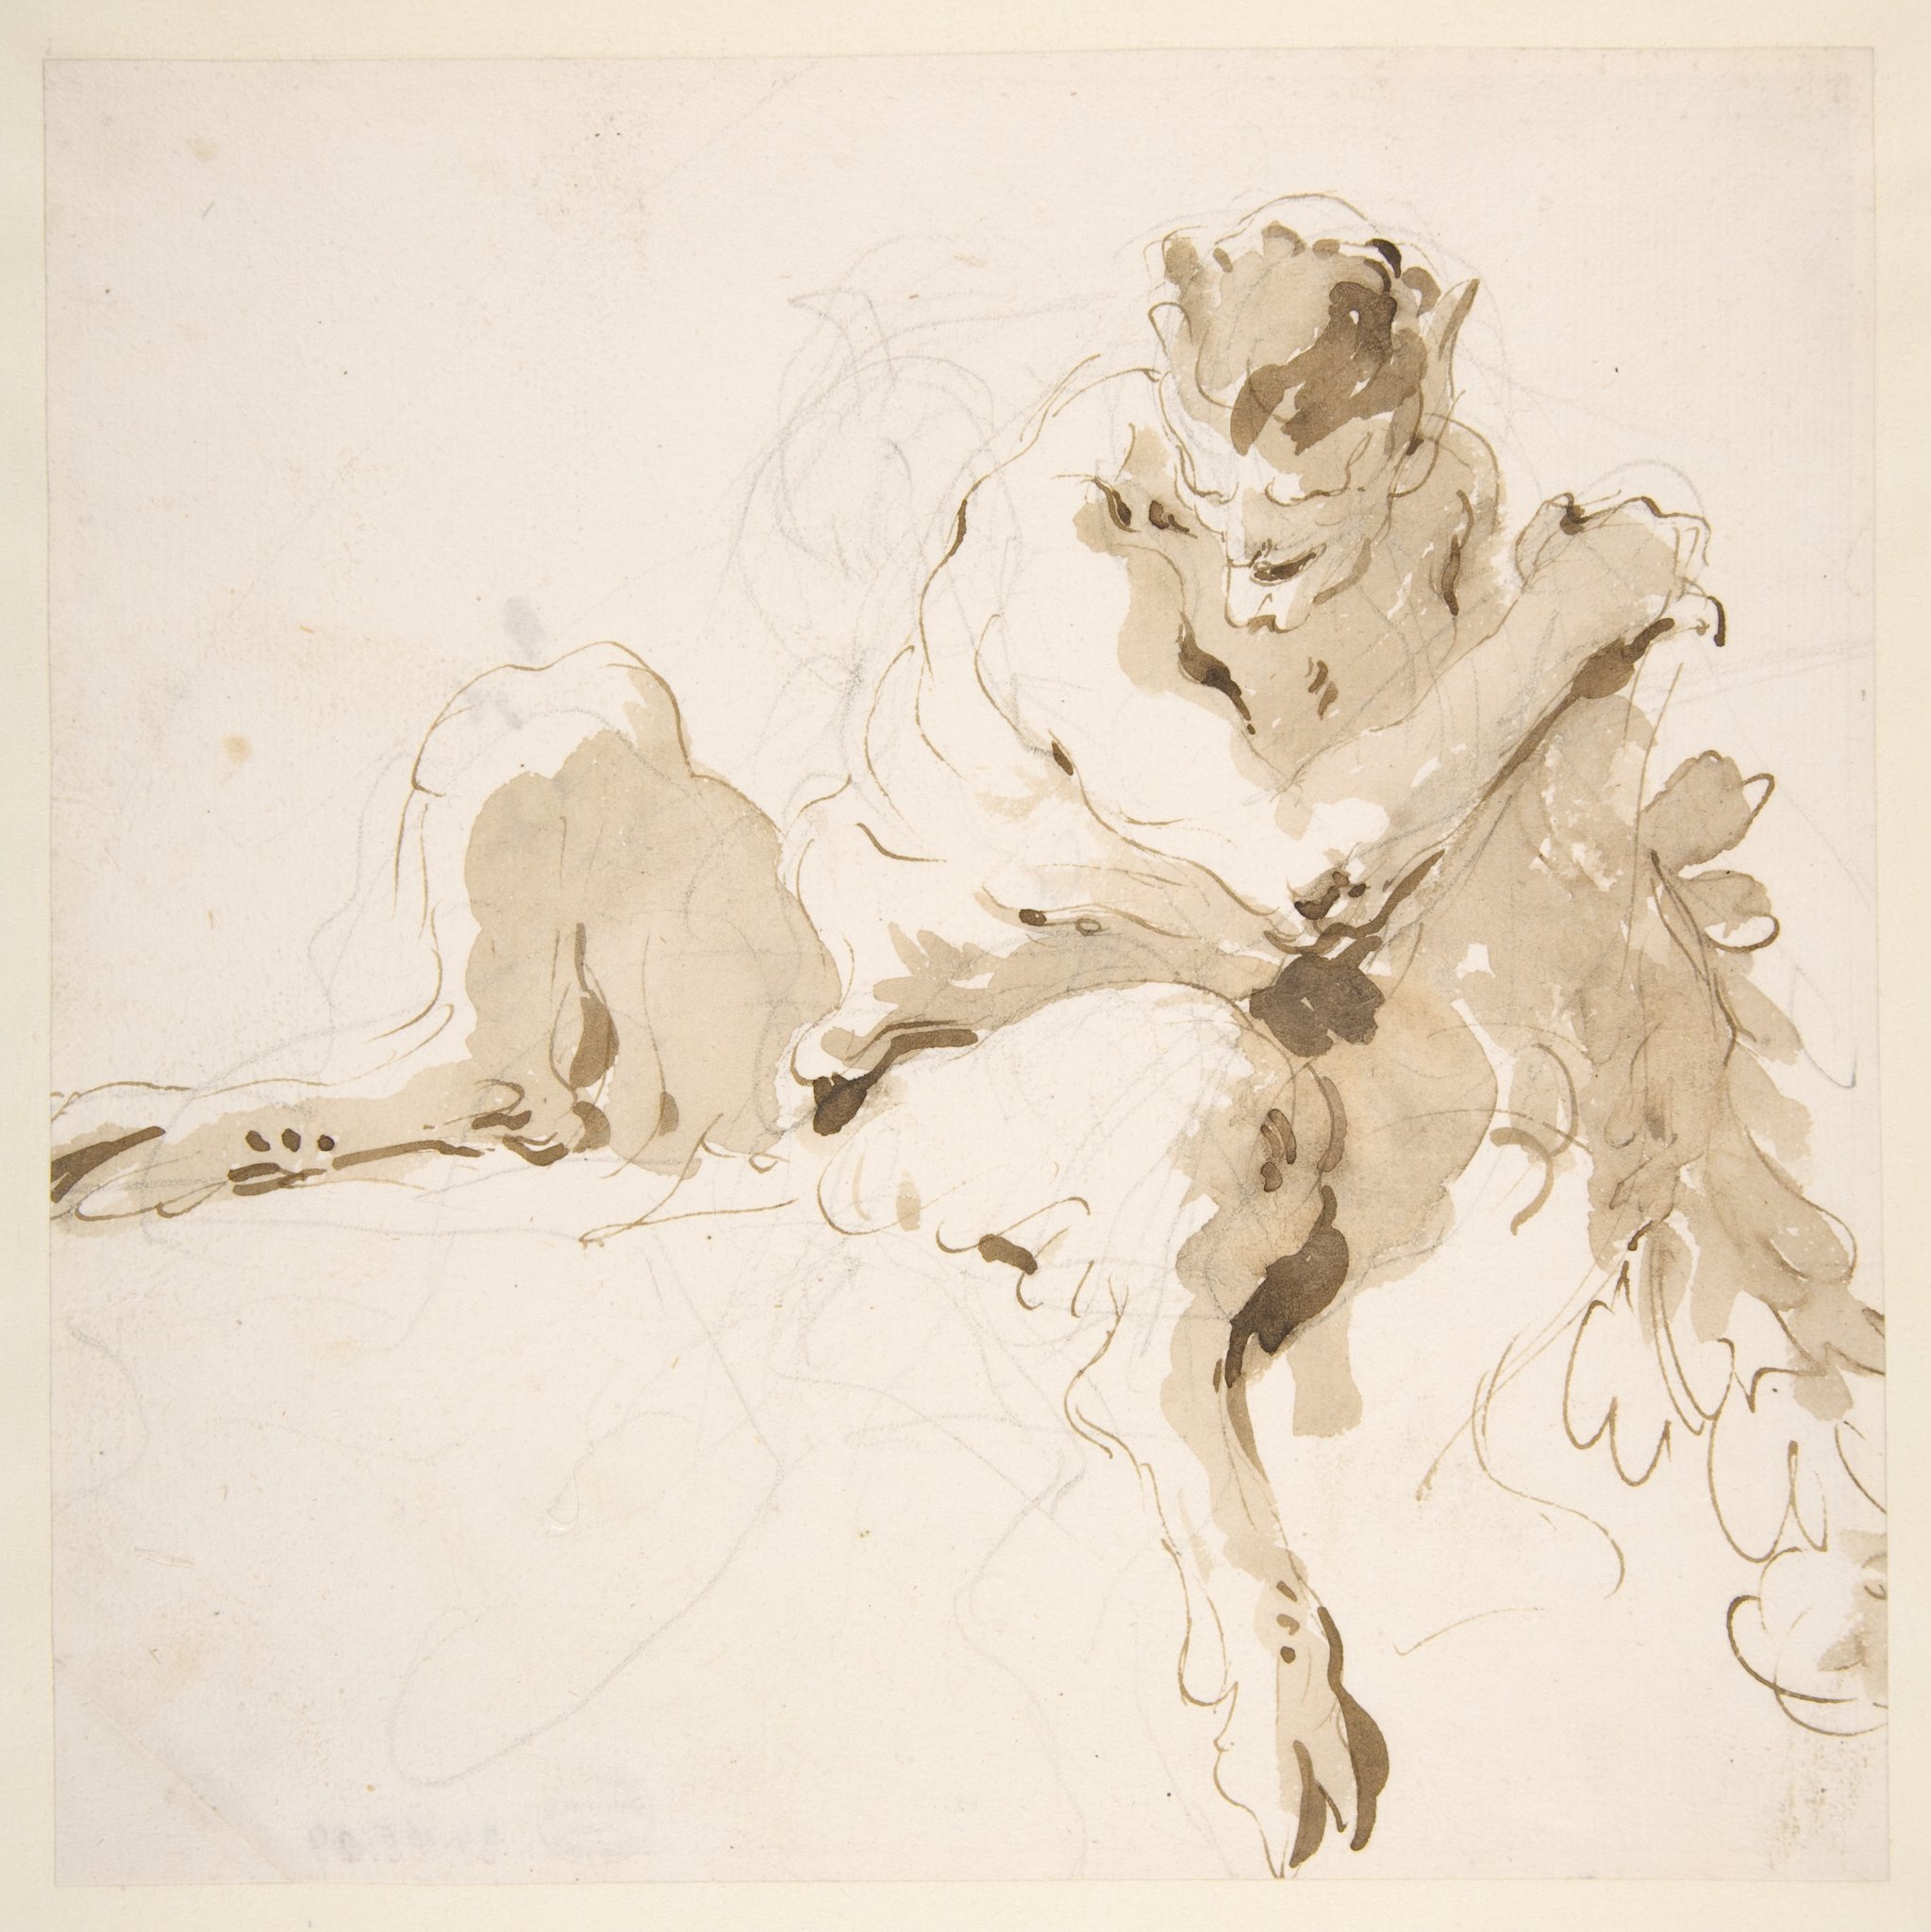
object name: drawing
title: Seated Satyr Holding a Garland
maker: giovanni battista tiepolo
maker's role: artist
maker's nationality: italian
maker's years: 1696-1770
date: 1696-1770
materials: chalk, ink, drawing material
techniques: brush, pen, wash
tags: garlands,satyrs